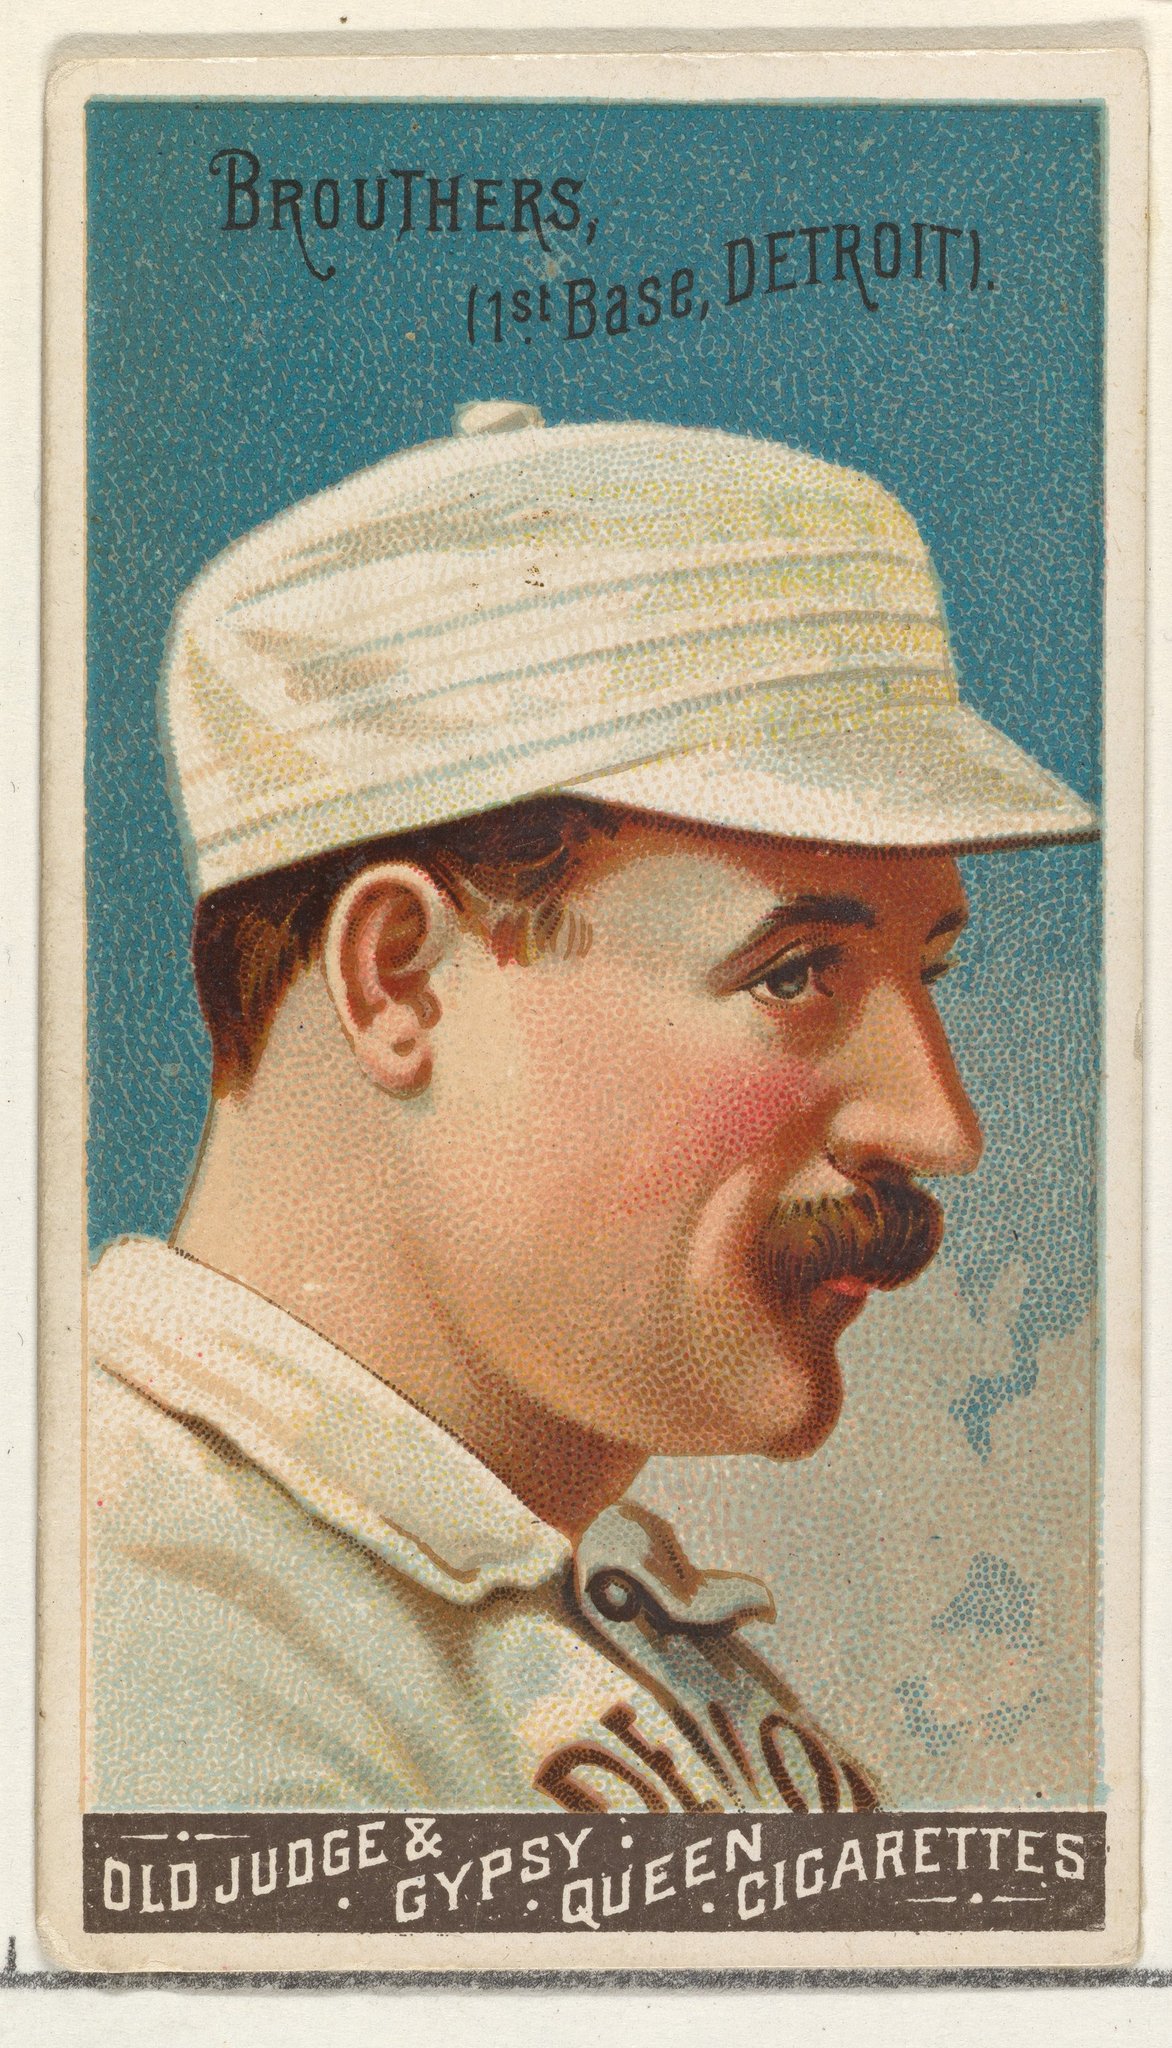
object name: baseball card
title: Dan Brouthers, 1st Base, Detroit, from the Goodwin Champion series for Old Judge and Gypsy Queen Cigarettes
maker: goodwin & company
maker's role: publisher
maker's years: 1850-1950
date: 1888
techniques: color lithograph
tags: men,profiles,baseball,athletes